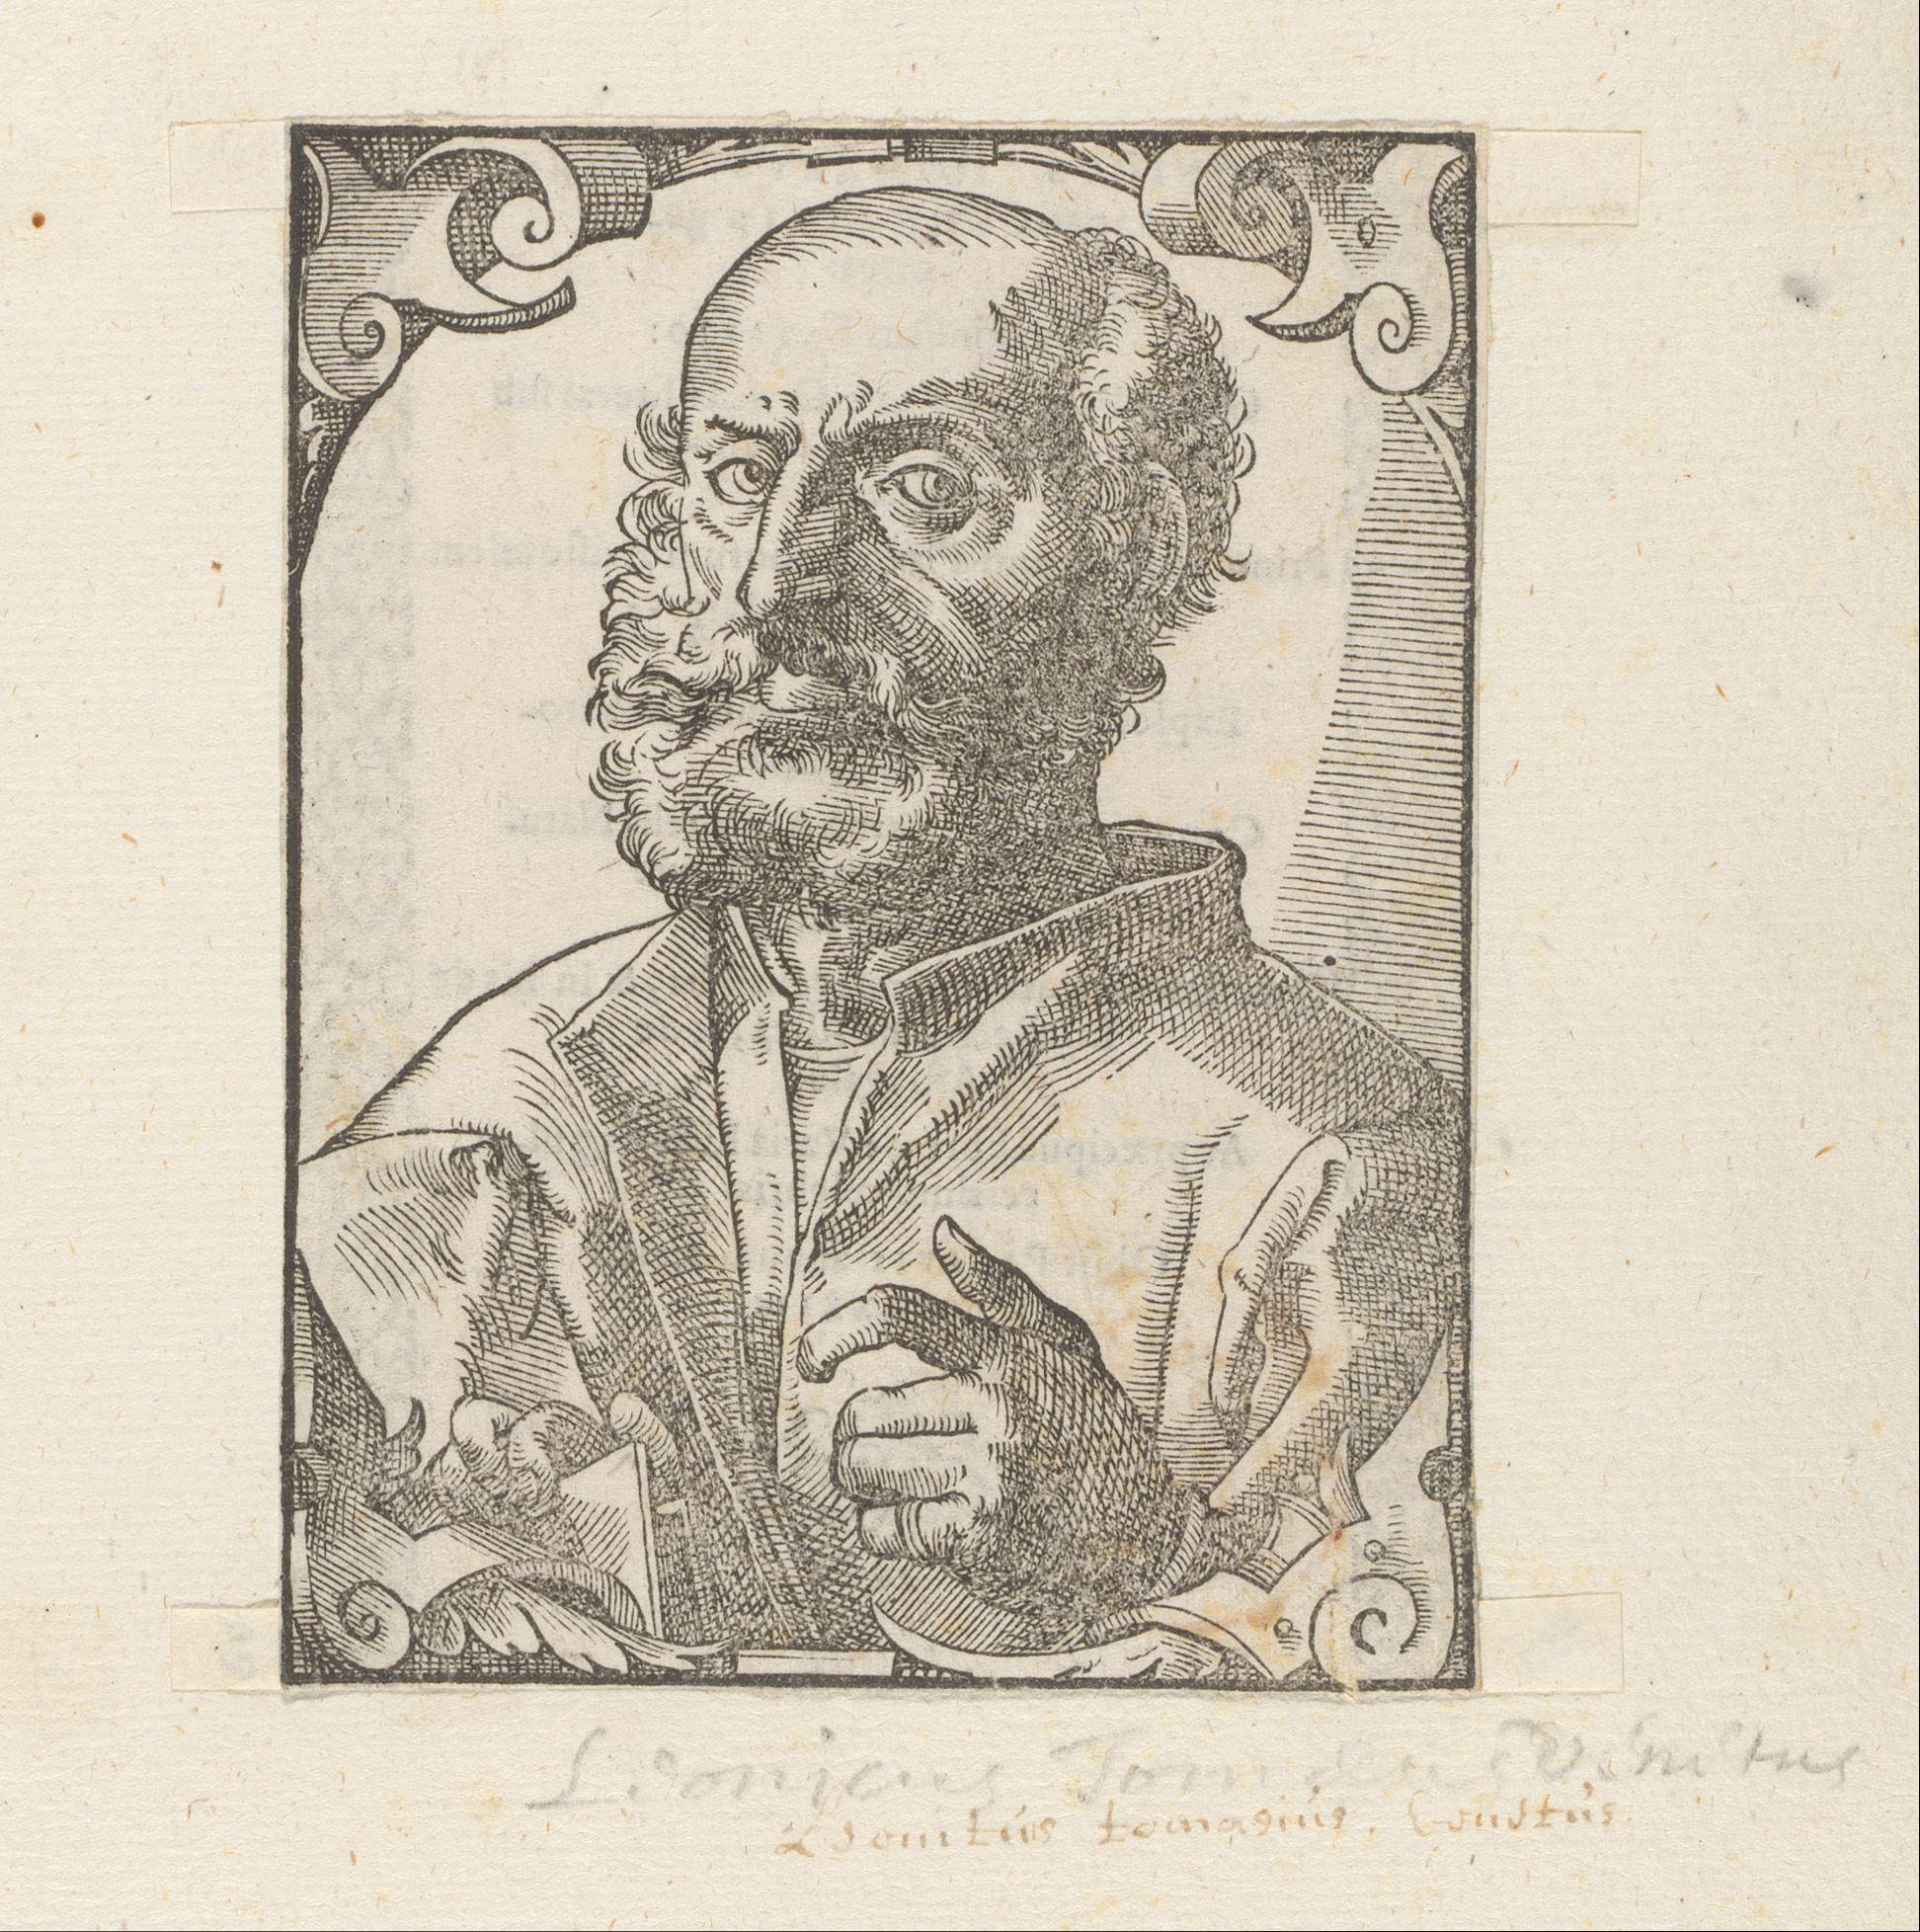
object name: print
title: Portret van Leonik Tomeu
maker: Anonymous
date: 1549-1577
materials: paper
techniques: letterpress printing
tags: venice, historical persons, scholar, philosopher (+ portrait of scholar, scientist)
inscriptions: collector's mark: Lugt 240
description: Prent gebruikt in: Giovio, Paolo. Elogia Virorum literis illustrium (...). Bazel: Peter Perna, 1577.